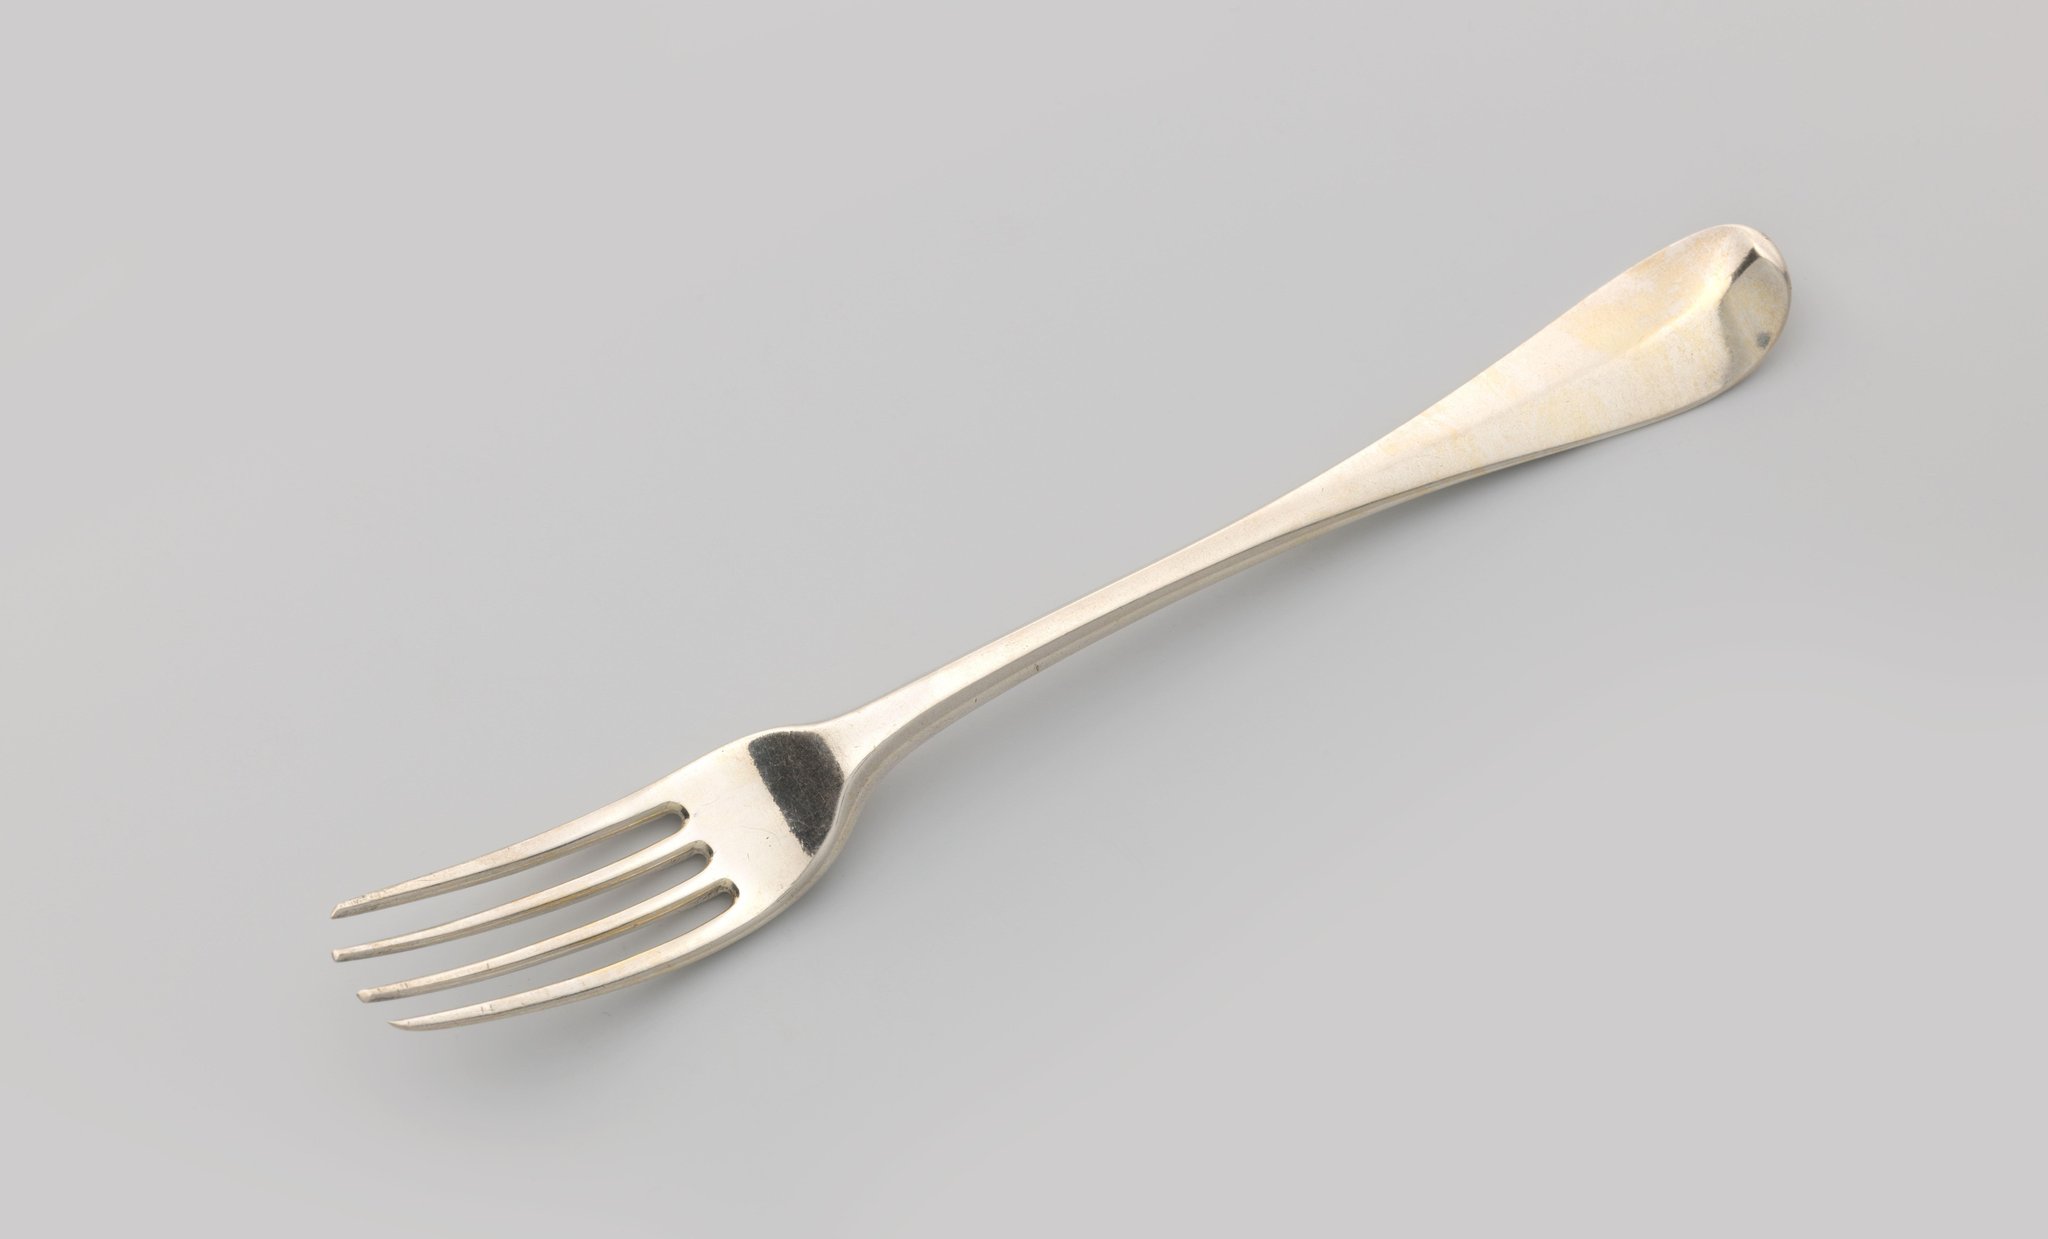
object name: fork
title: Vork met vier tanden en een gebogen steel met afgerond uiteinde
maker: fredrik rudolf precht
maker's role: silversmith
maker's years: 1714-1787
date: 1766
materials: silver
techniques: engraving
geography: amsterdam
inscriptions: maker's mark, inscription: ‘MVDM/1766’, alloy mark, date letter: ‘G’, town mark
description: De viertandige vork is eveneens met dubbel lof verbonden met de steel, die van hetzelfde model is als die van de lepel. Op de onderzijde van beide stelen (A en B) is gegraveerd: MVDM/1766.